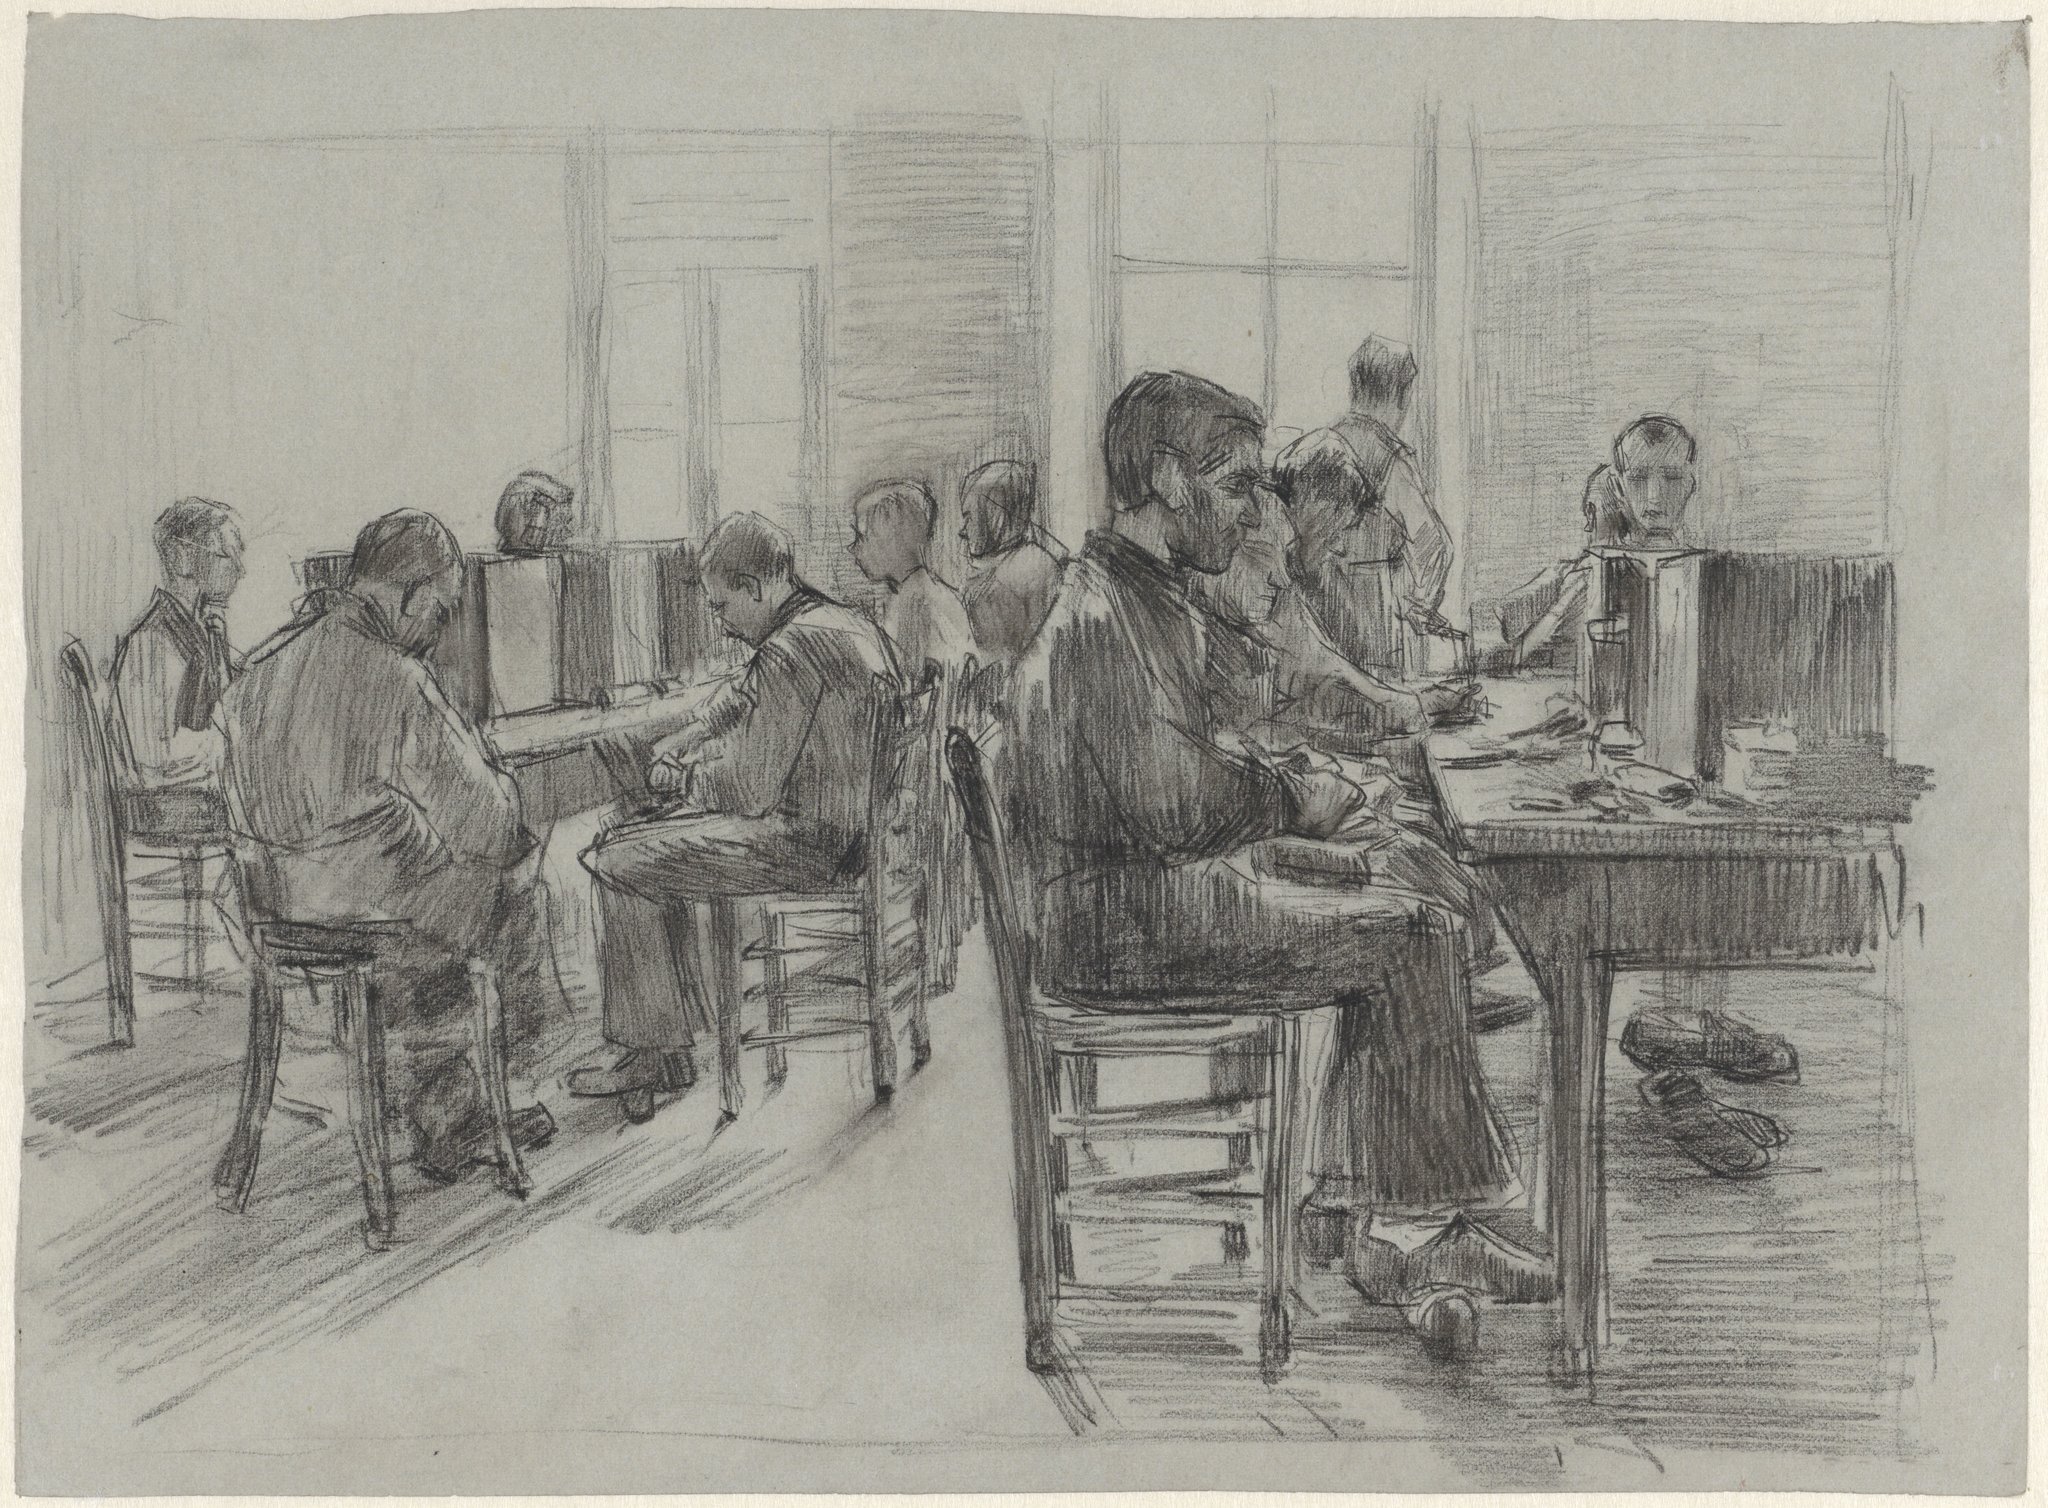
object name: drawing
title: Zaal in een blindeninrichting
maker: anthon gerhard alexander van rappard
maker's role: draughtsman, print maker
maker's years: 1858-1892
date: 1868-1892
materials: charcoal, paper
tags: blind, blindness, interior of the house